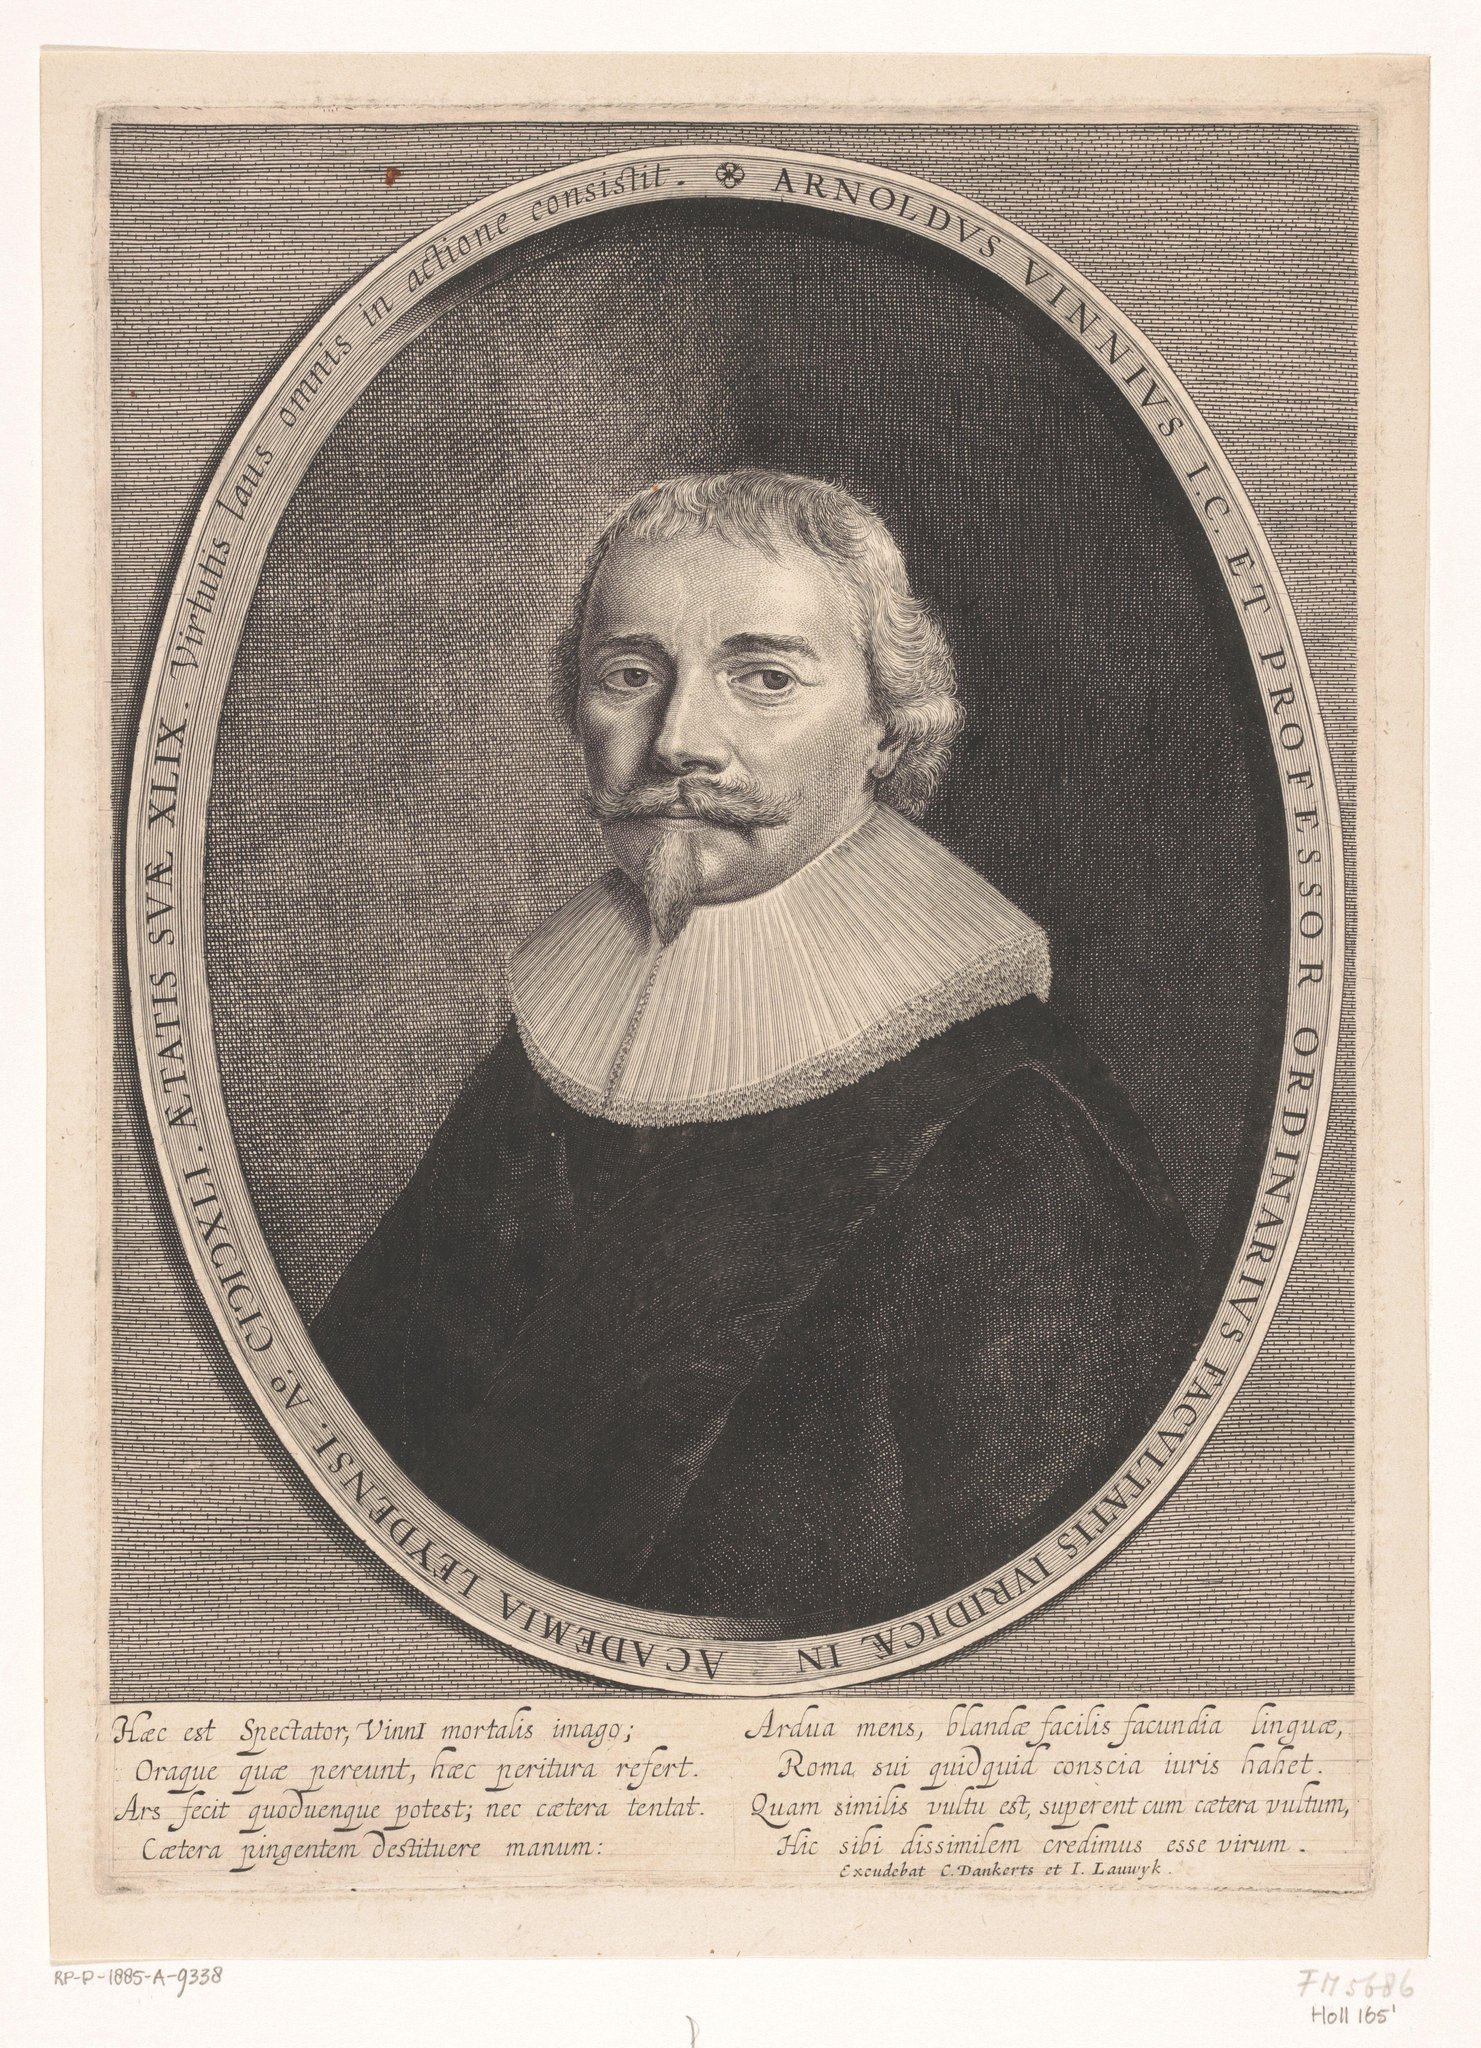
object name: print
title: Arnoldvs Vinnivs I.C. (...) aetatis svae XLIX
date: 1641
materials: paper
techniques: engraving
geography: amsterdam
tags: professor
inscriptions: collector's mark: Lugt 2228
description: Portret van Arnoldus Vinnius op 49-jarige leeftijd, professor aan de juridische faculteit Leiden. Borststuk in ovale omlijsting met motto Virtutis laus omnis in actione consistit. Onder in marge een Latijns vers van Marcus Zuerius Boxhorn.